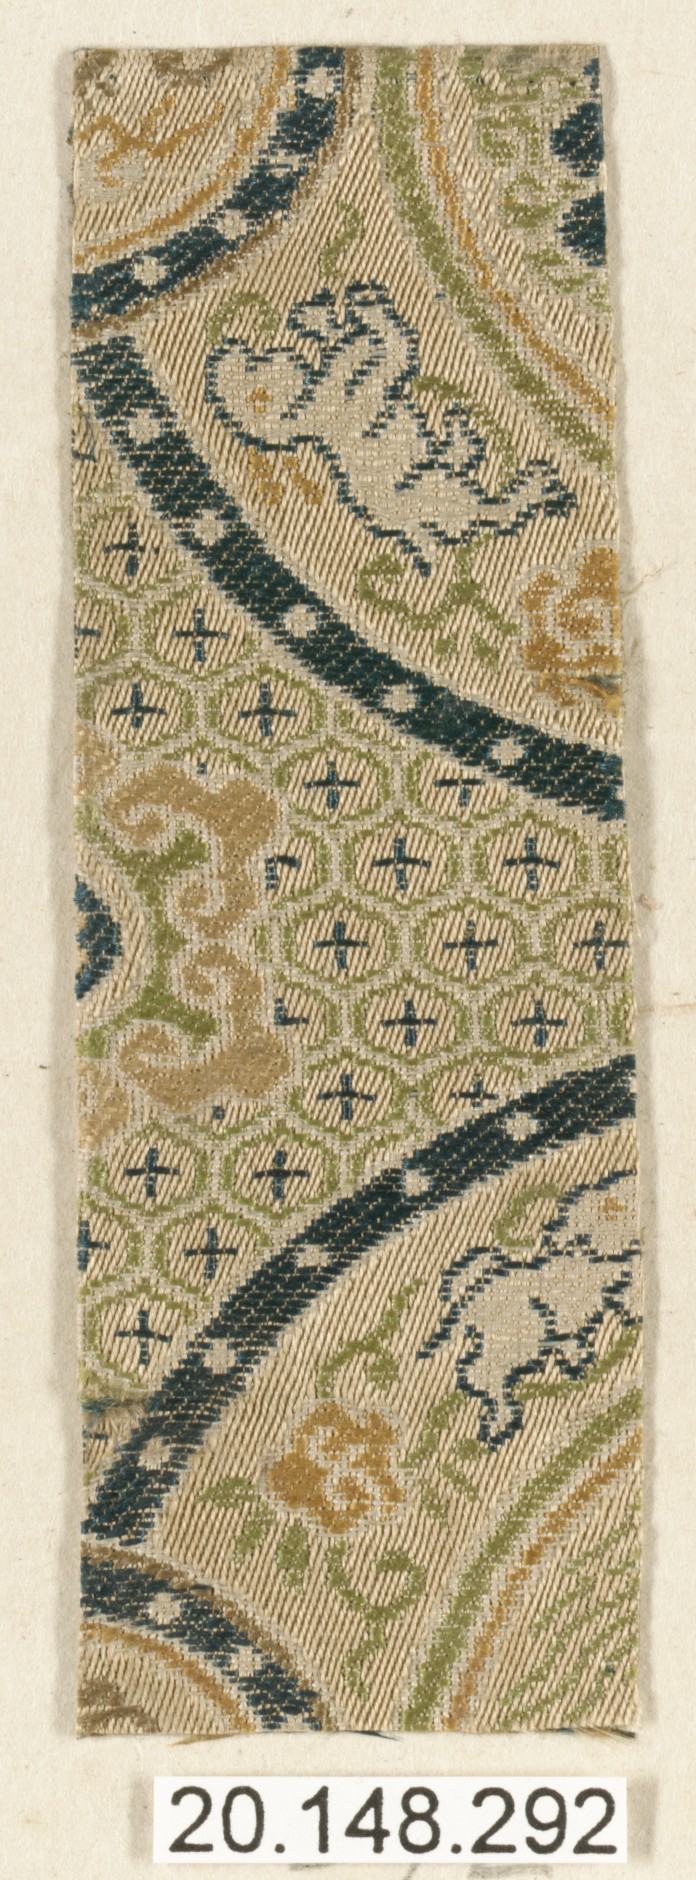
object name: piece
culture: chinese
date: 1601-1700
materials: silk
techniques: compound weave